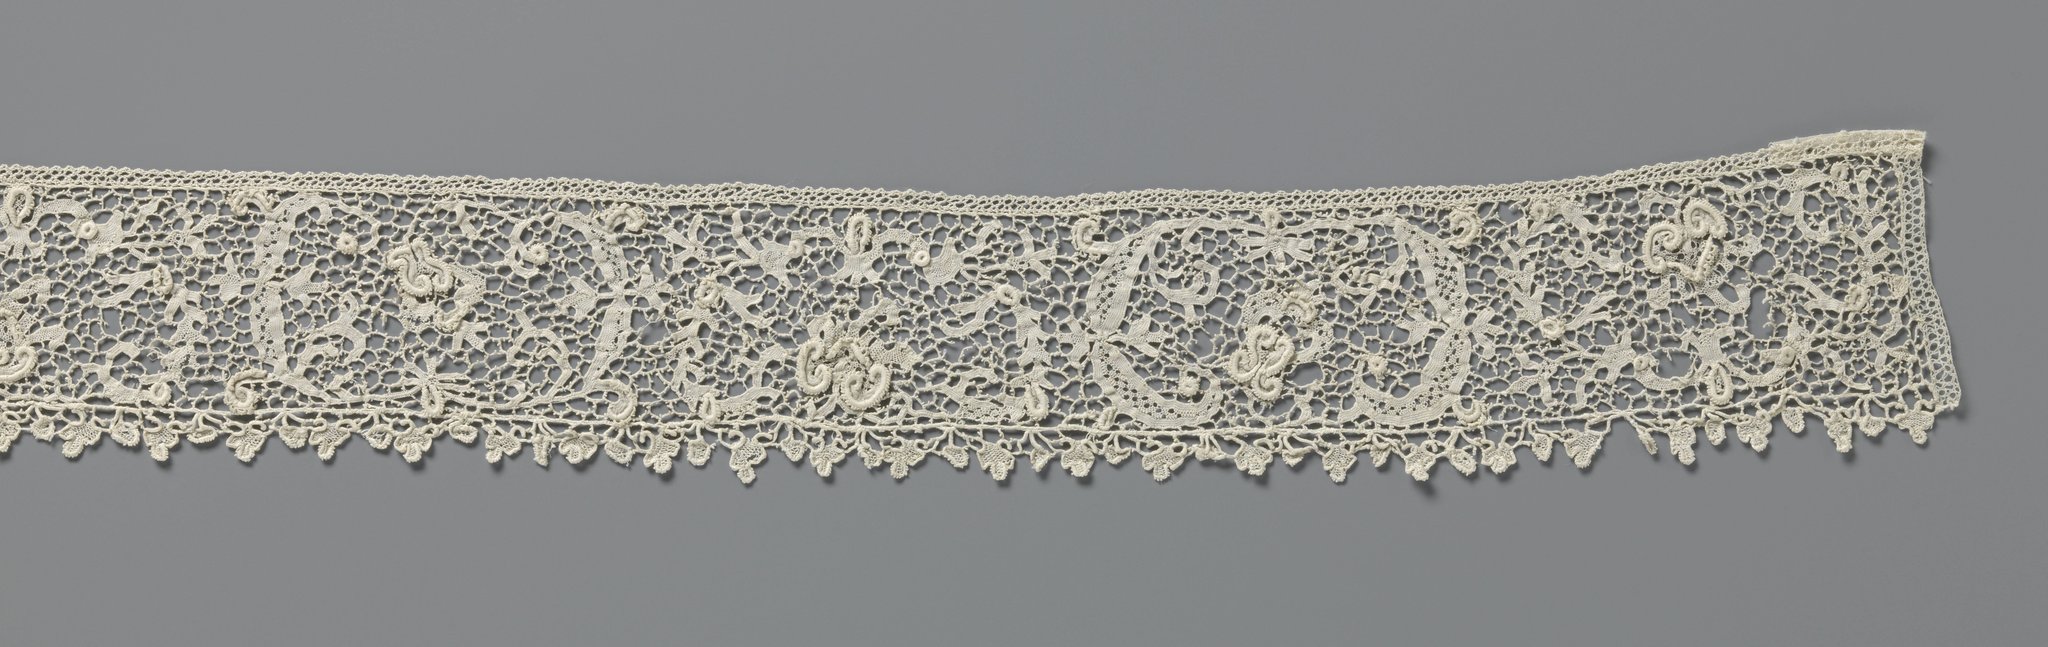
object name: strip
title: Strook naaldkant met kroon in ovaal cartouche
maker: Anonymous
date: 1700-1724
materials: linen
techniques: needle lace, lace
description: Strook naturelkleurig naaldkant, point de France. Patroon zonder rapport, maar met terugkerende en deels gespiegelde motieven, waaronder een ovaal cartouche met een kroon erin. Zeshoekige grond met gepicoteerde spijlen. Volwerk met uitsparingen en grotendeels zonder reliëf, op enkele kleinere motieven met kordons na. Aan de rechte rand aan de onderzijde hangen kleine palmetten en ovaaltjes aan gekordonneerde en deels gepicoteerde spijlen. De bovenzijde en zijkanten zijn afgezet met een rand kloskant.